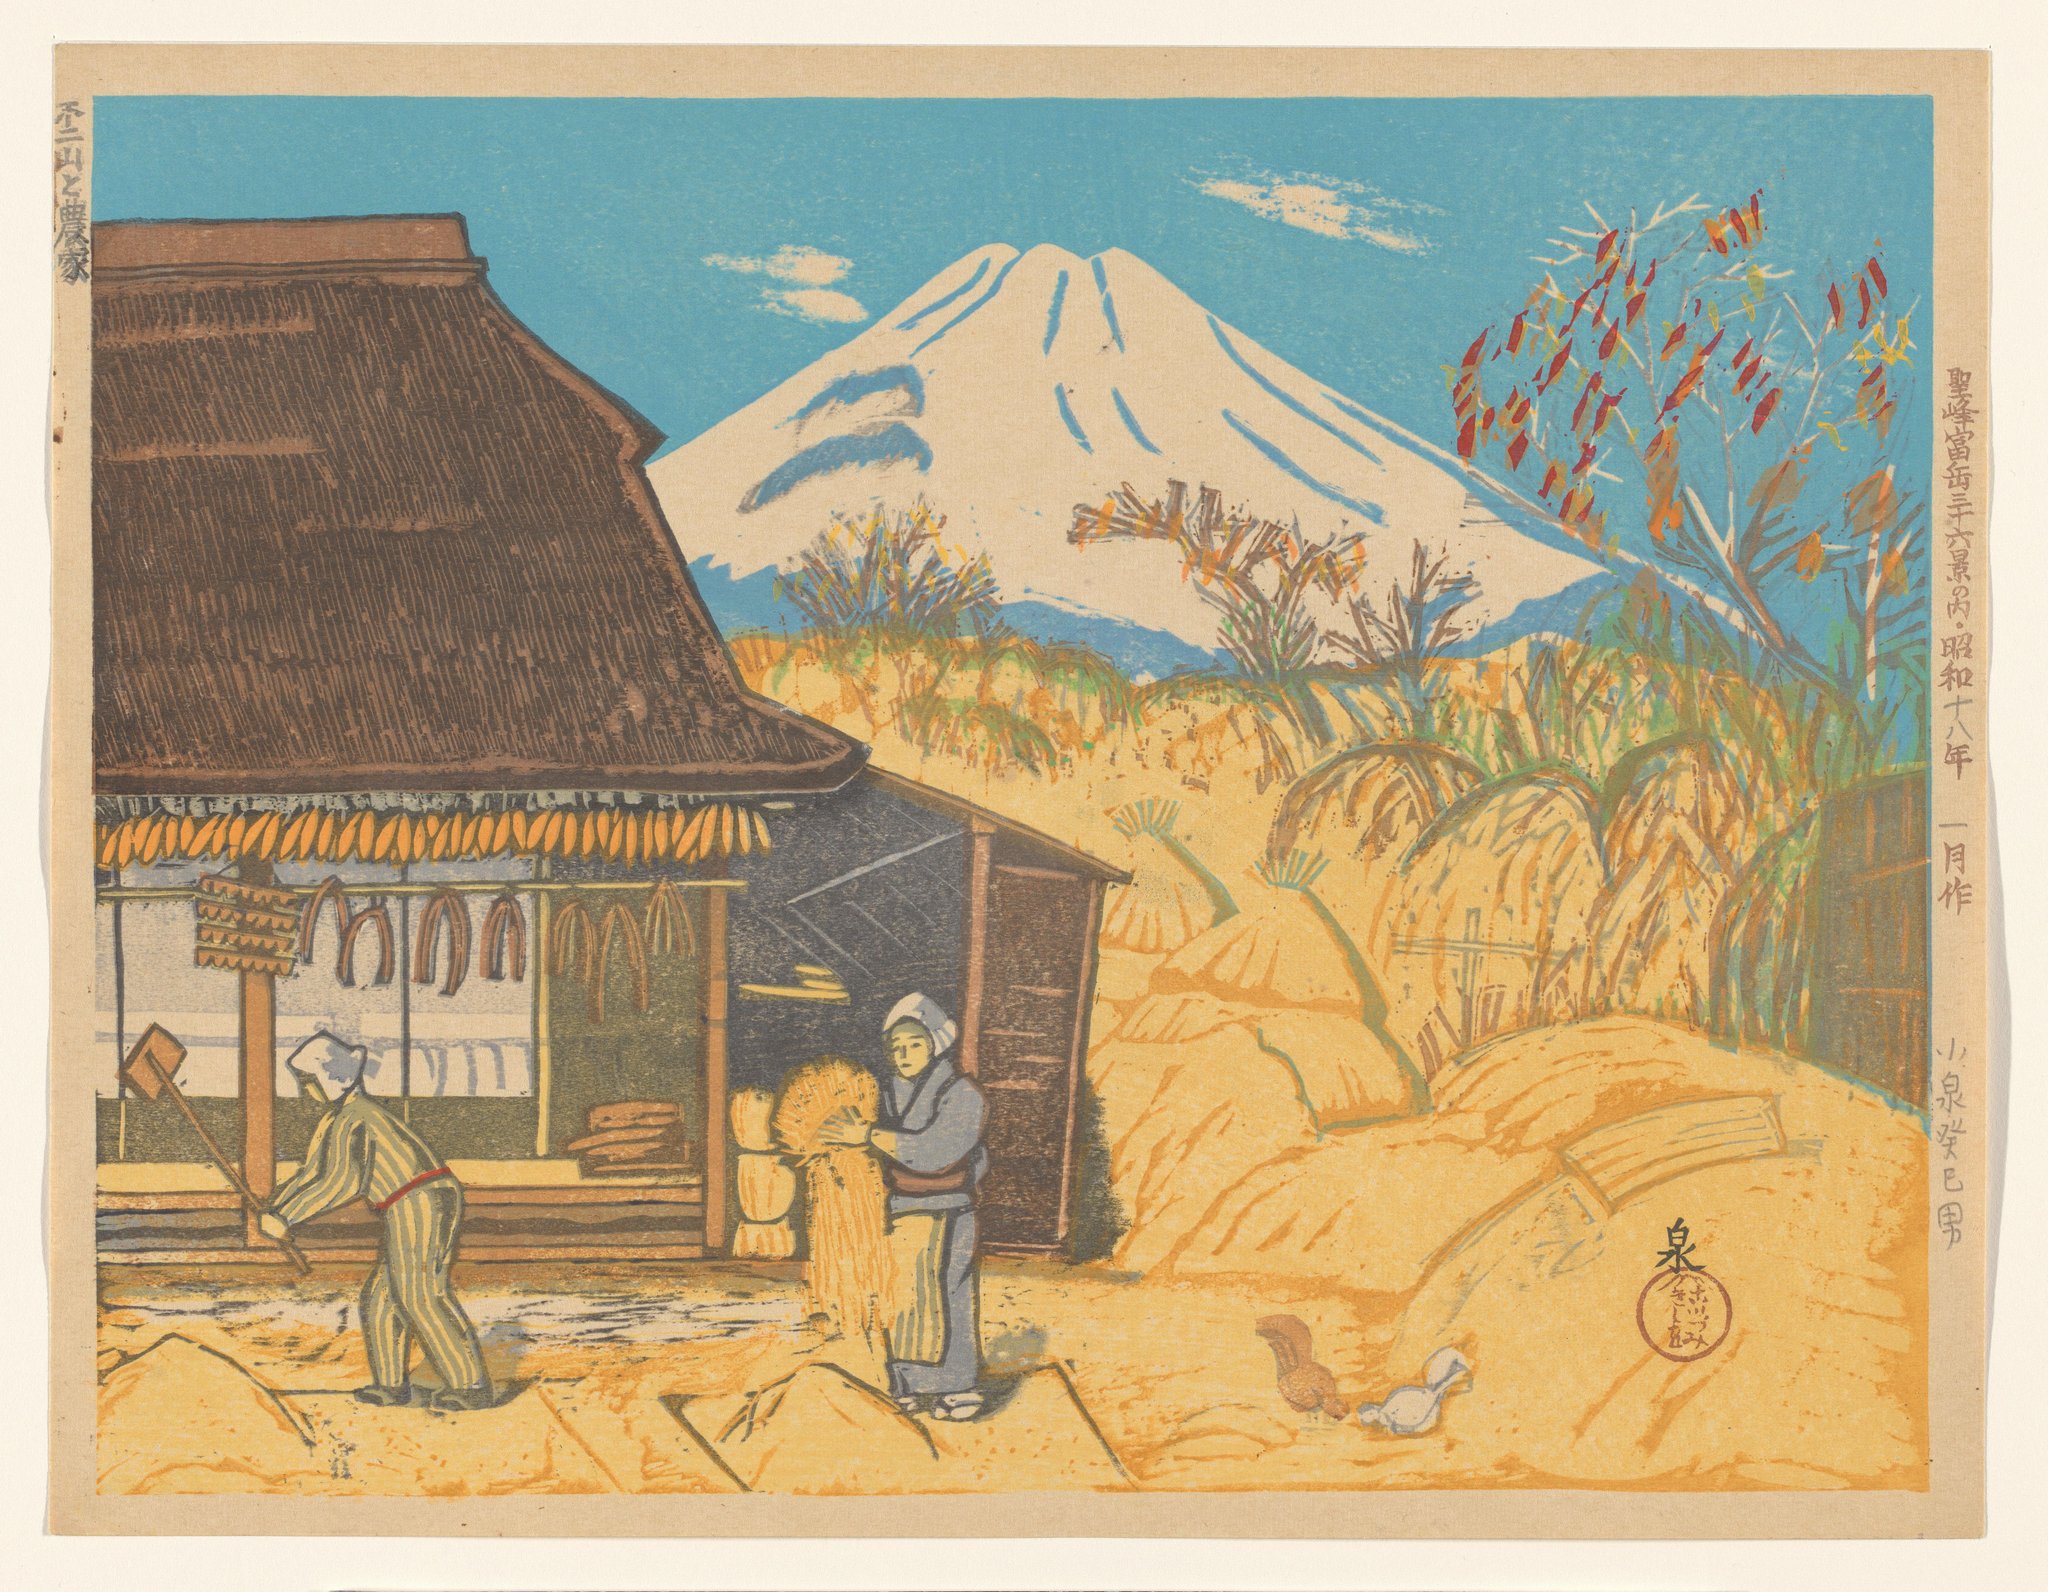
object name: print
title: Mount Fuji and a farmhouse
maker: koizumi kishio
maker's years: 1893-1945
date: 1901-1943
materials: paper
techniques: woodcut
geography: japan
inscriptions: signature: ‘小泉癸巳男’, seal: ‘こいづみきしを’, signature: ‘泉’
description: Een boer en boerin sorteren hun oogst, naast hen grazen twee kippen. Achter de boerderij is in de verte de piek van de Fuji-berg zichtbaar. Koizumi Kishio begon in 1940 aan zijn project 'Zesendertig gezichten op de heilige berg Fuji', een knipoog naar de welbekende prenten uit de jaren 1830 van Katsushika Hokusai (1760–1849). Vanwege de geallieerde bombardementen vluchtte hij naar zijn schoonouders in Saitama, ten noorden van Tokyo. Hij voltooide 23 ontwerpen voor hij bezweek aan ziekte in 1945.